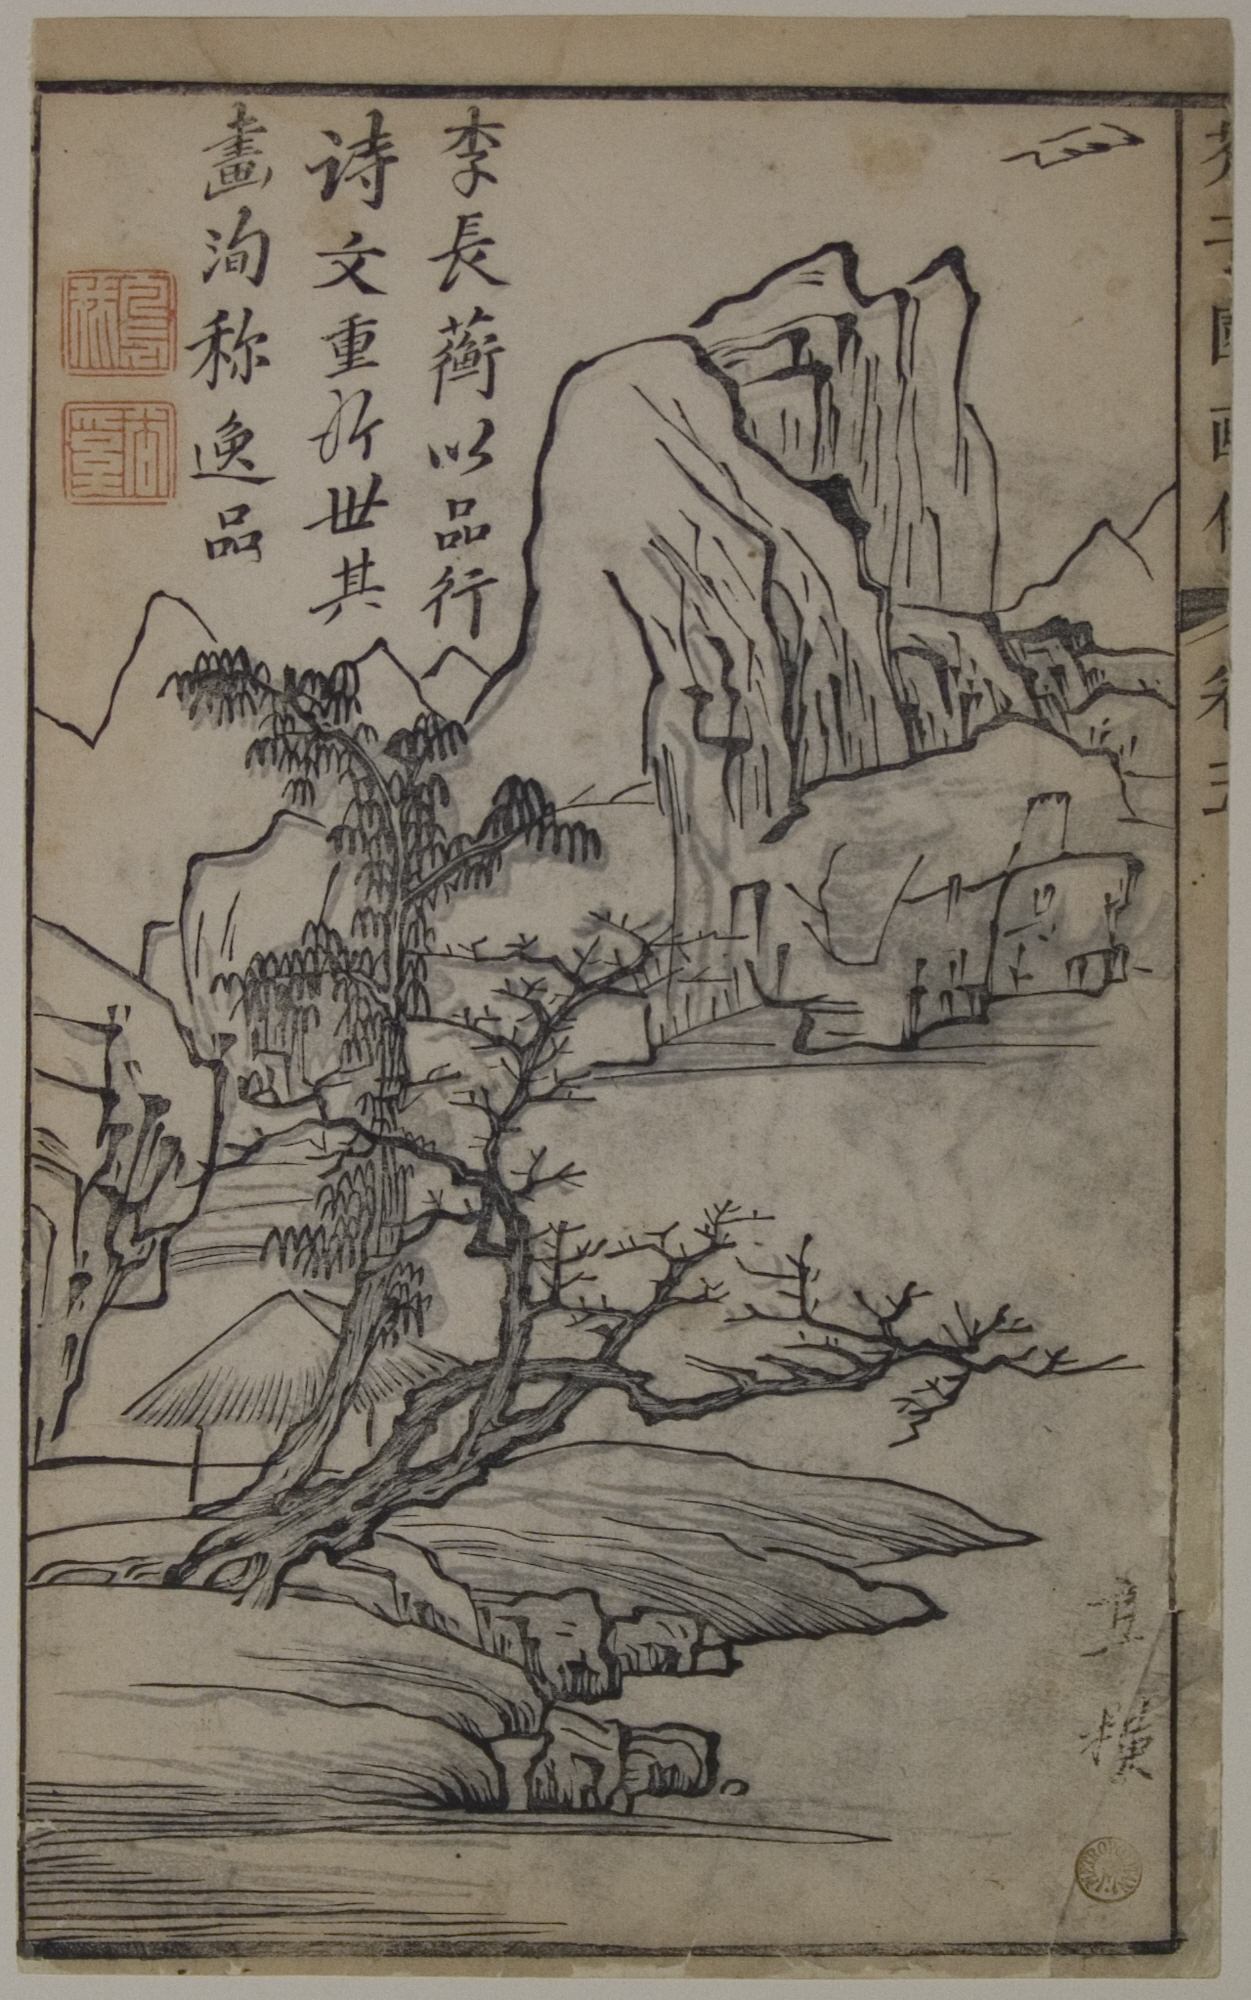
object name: print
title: Summer and Paulownia Tree (A Page from the Jie Zi Yuan)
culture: chinese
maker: shen zhou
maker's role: artist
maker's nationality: chinese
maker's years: 1427-1509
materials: ink, paper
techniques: polychrome, woodblock print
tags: landscapes